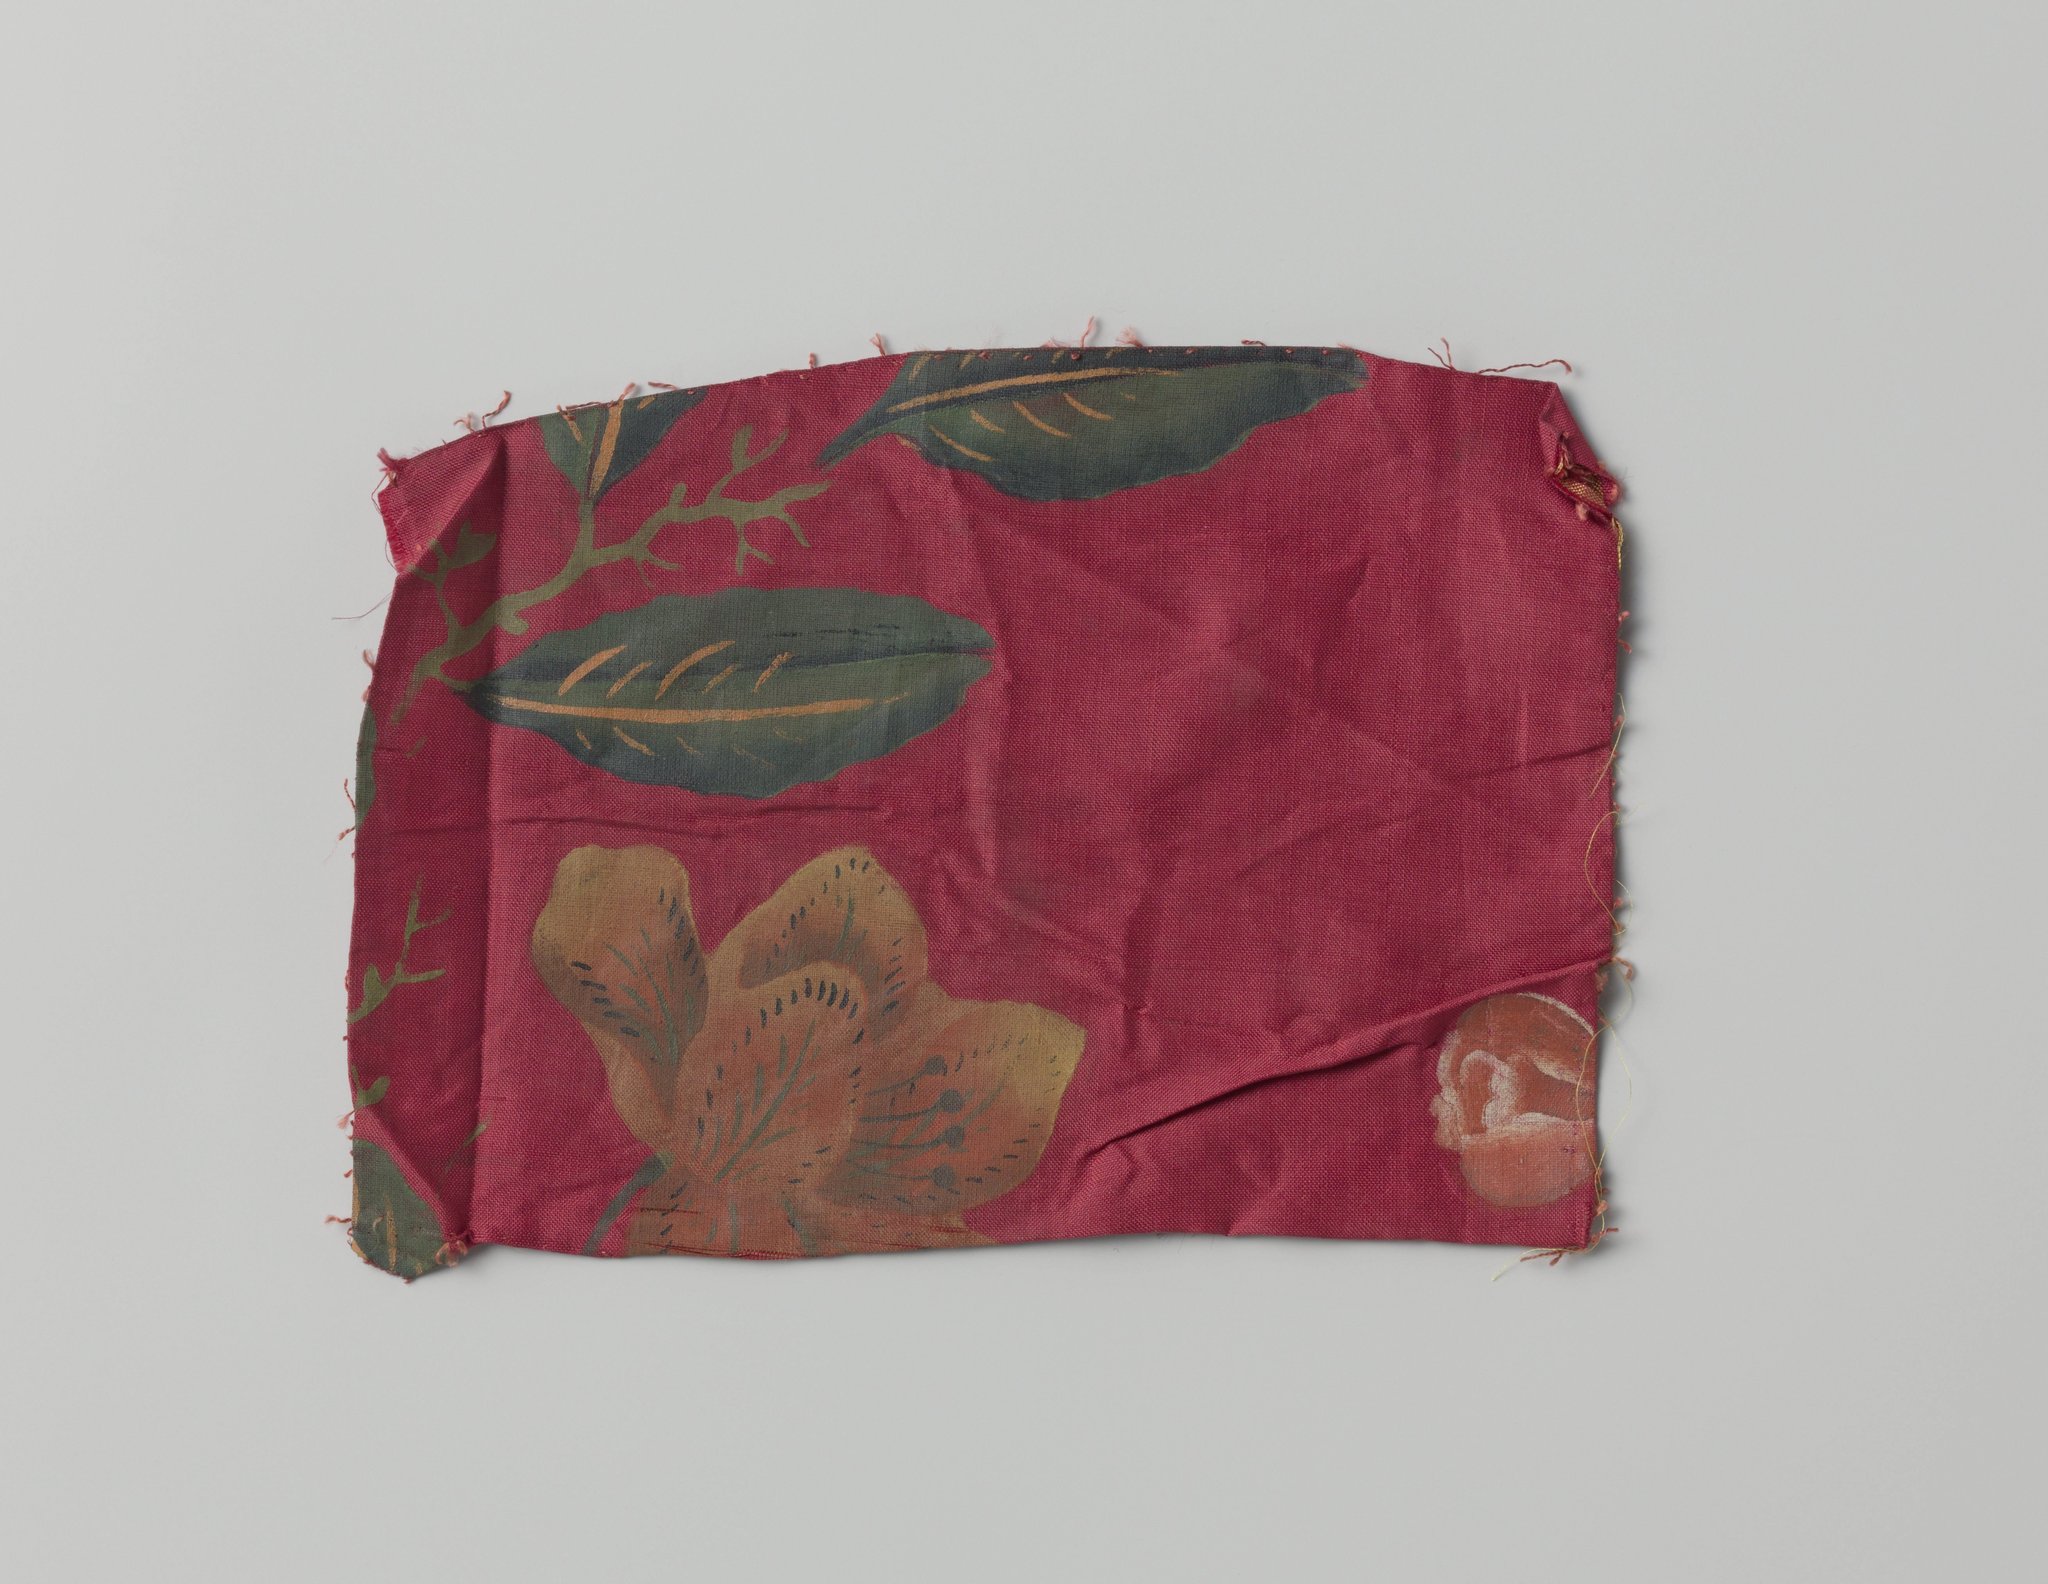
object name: covering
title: Fragment van een hoes voor stoelzitting, van bedrukte zijde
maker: Anonymous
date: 1770-1780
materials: linen, paint, silk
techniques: printing, weave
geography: netherlands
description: Drie hoezen voor stoelzittingen. De hoezen zijn gemaakt van bedrukte zijde. Op een rode grond zijn veelkleurige bloemtakken gedrukt. De hoezen hebben een linnen voering.